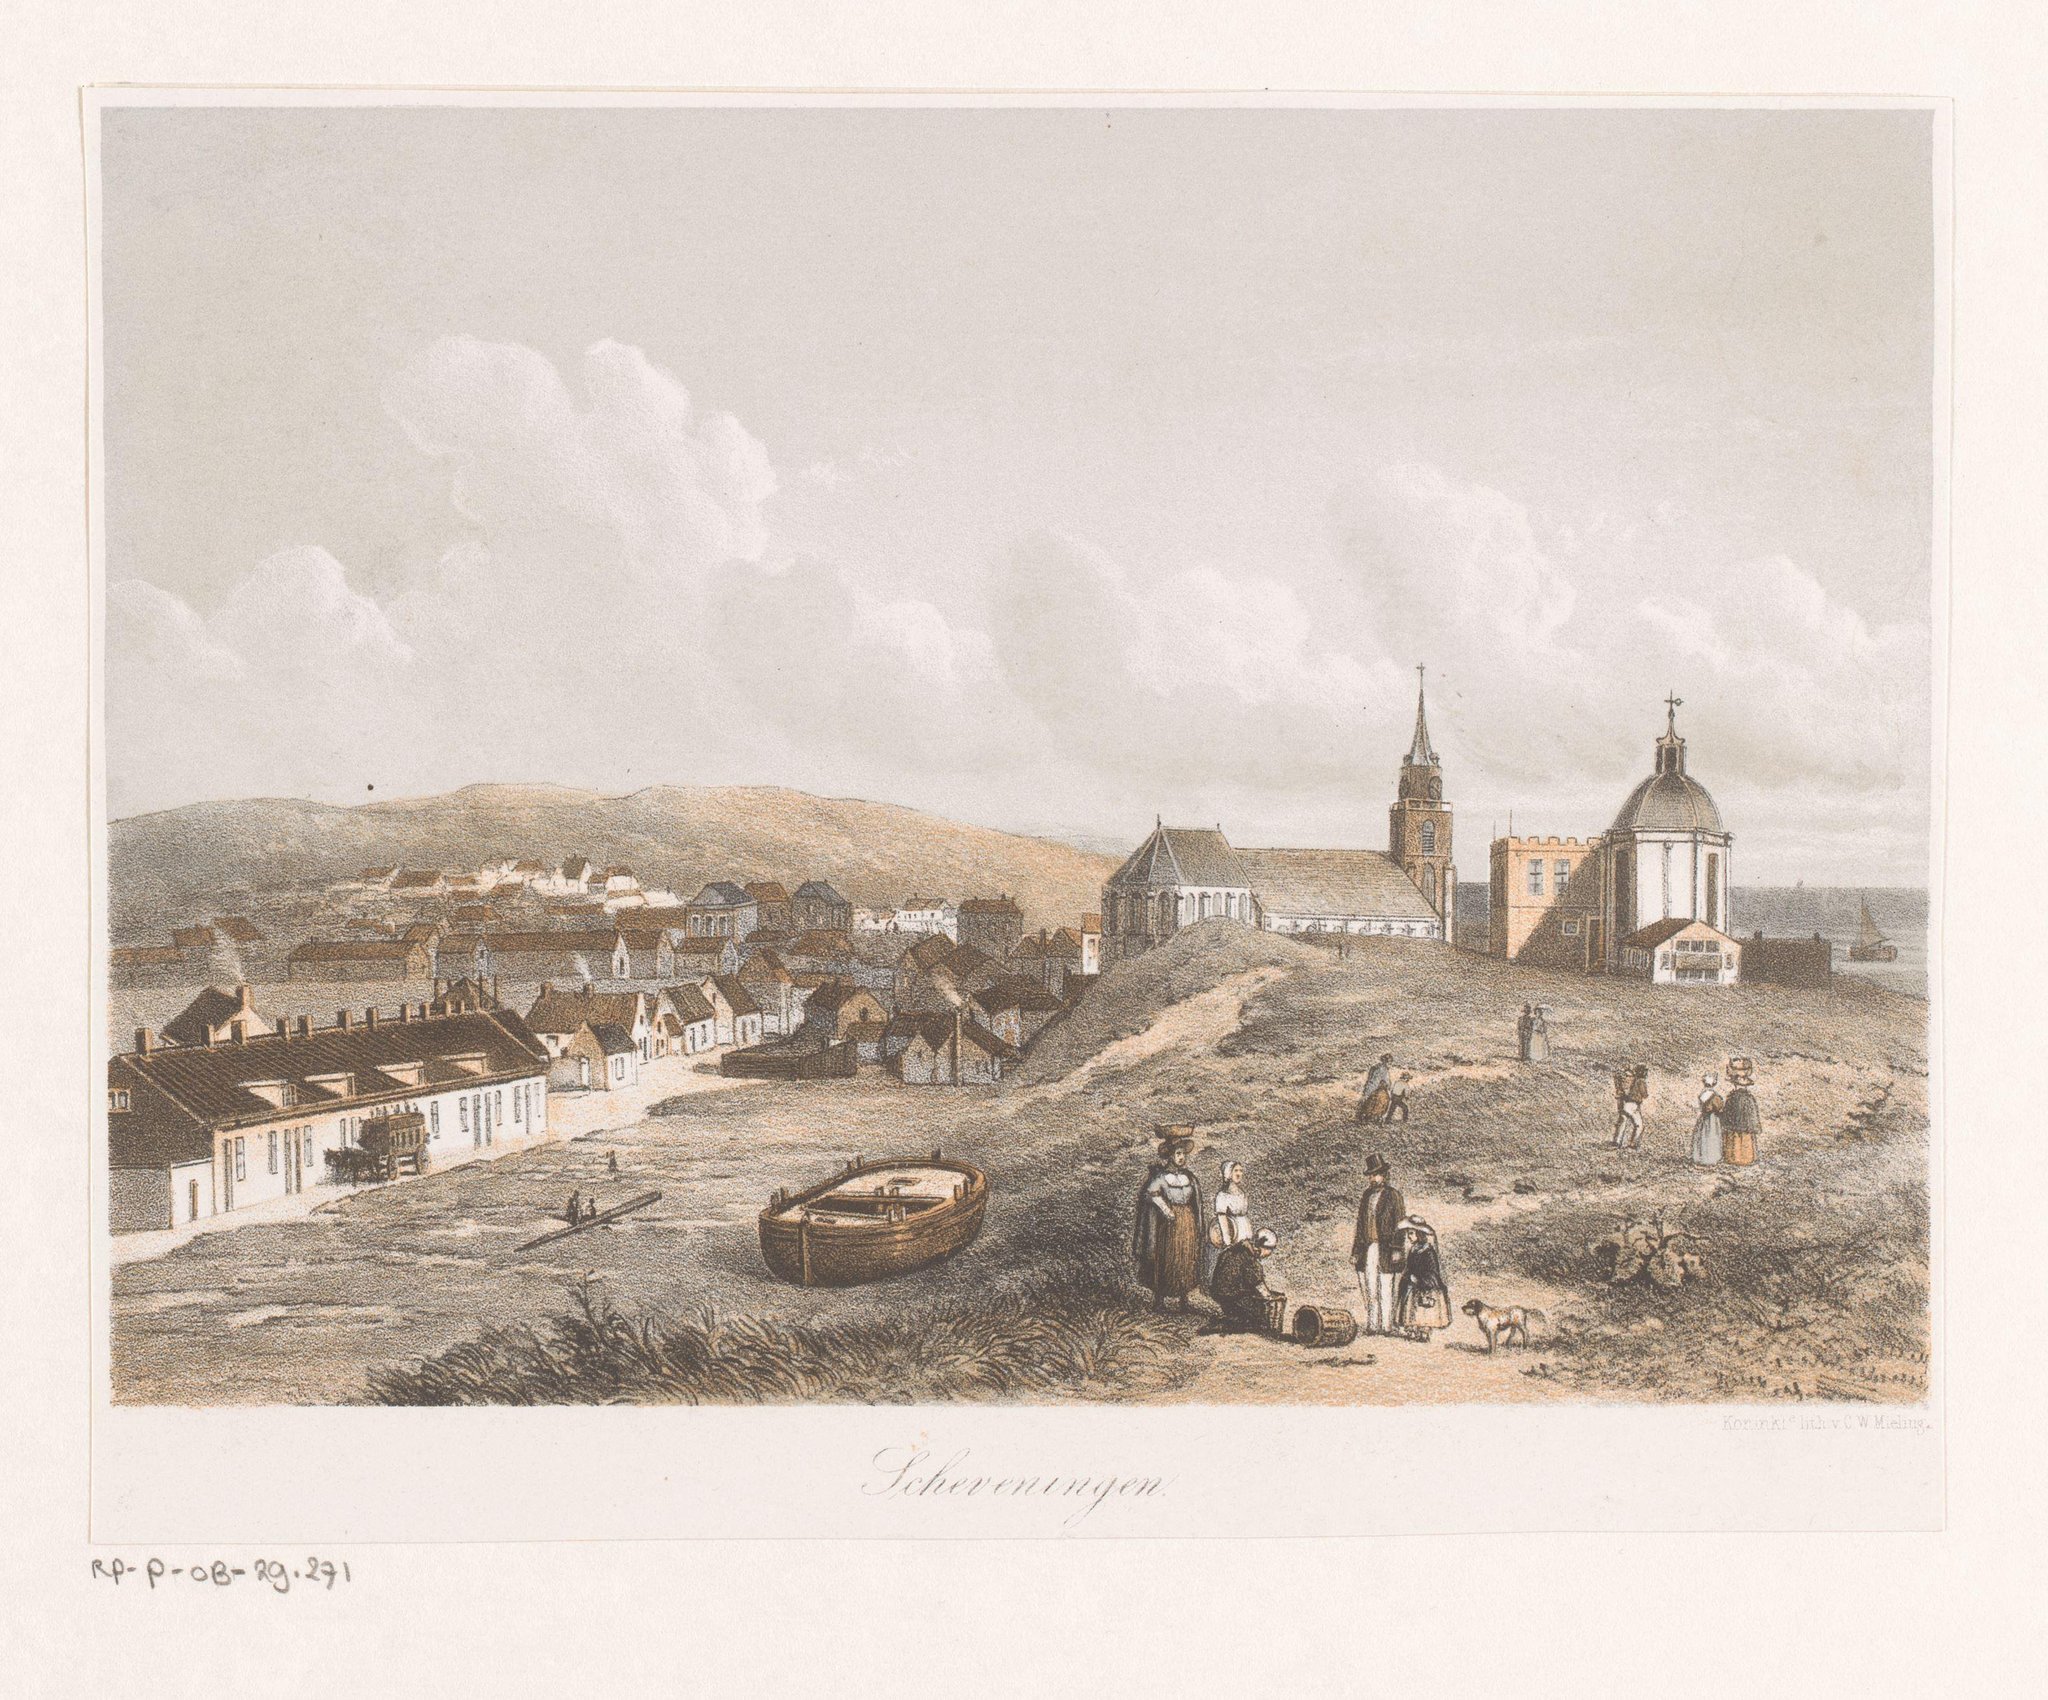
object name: print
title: Gezicht op Scheveningen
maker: Anonymous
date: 1863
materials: paper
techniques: tone lithography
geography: the hague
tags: dune coast, city-view in general; 'veduta', beach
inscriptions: collector's mark: Lugt 2228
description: Links, achter de duinen, ligt Scheveningen. Rechts het strand en de zee.